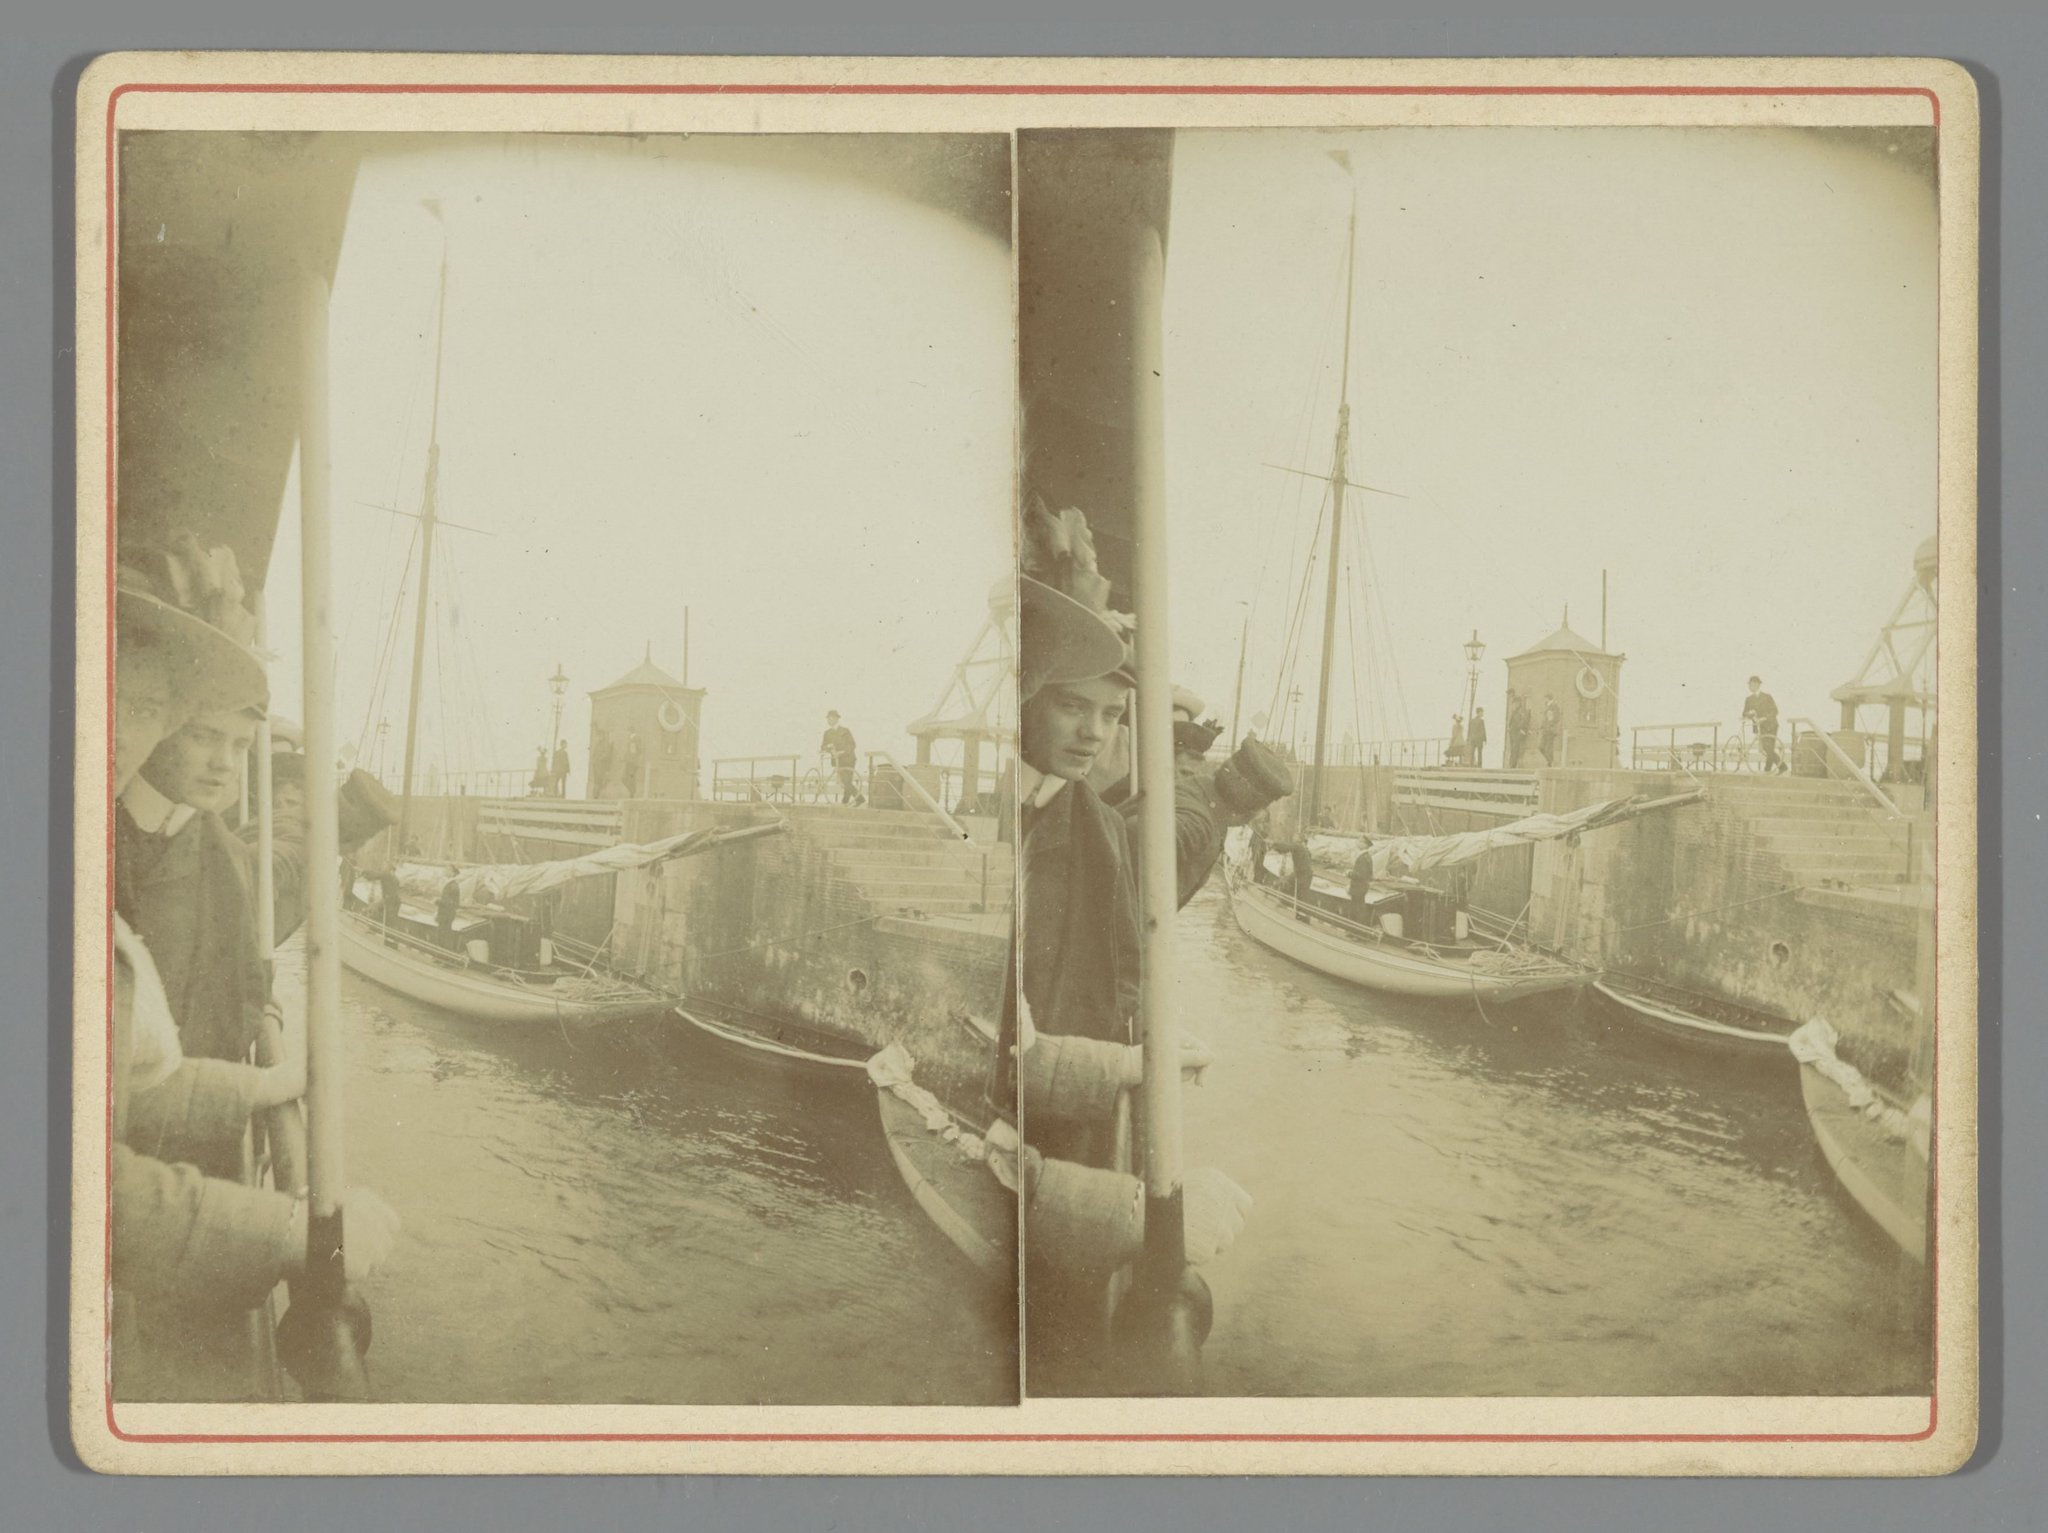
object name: stereograph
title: Oranjesluis bij Durgerdam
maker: Anonymous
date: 1900-1920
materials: paper, cardboard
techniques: gelatin silver print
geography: durgerdam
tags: sluice, weir